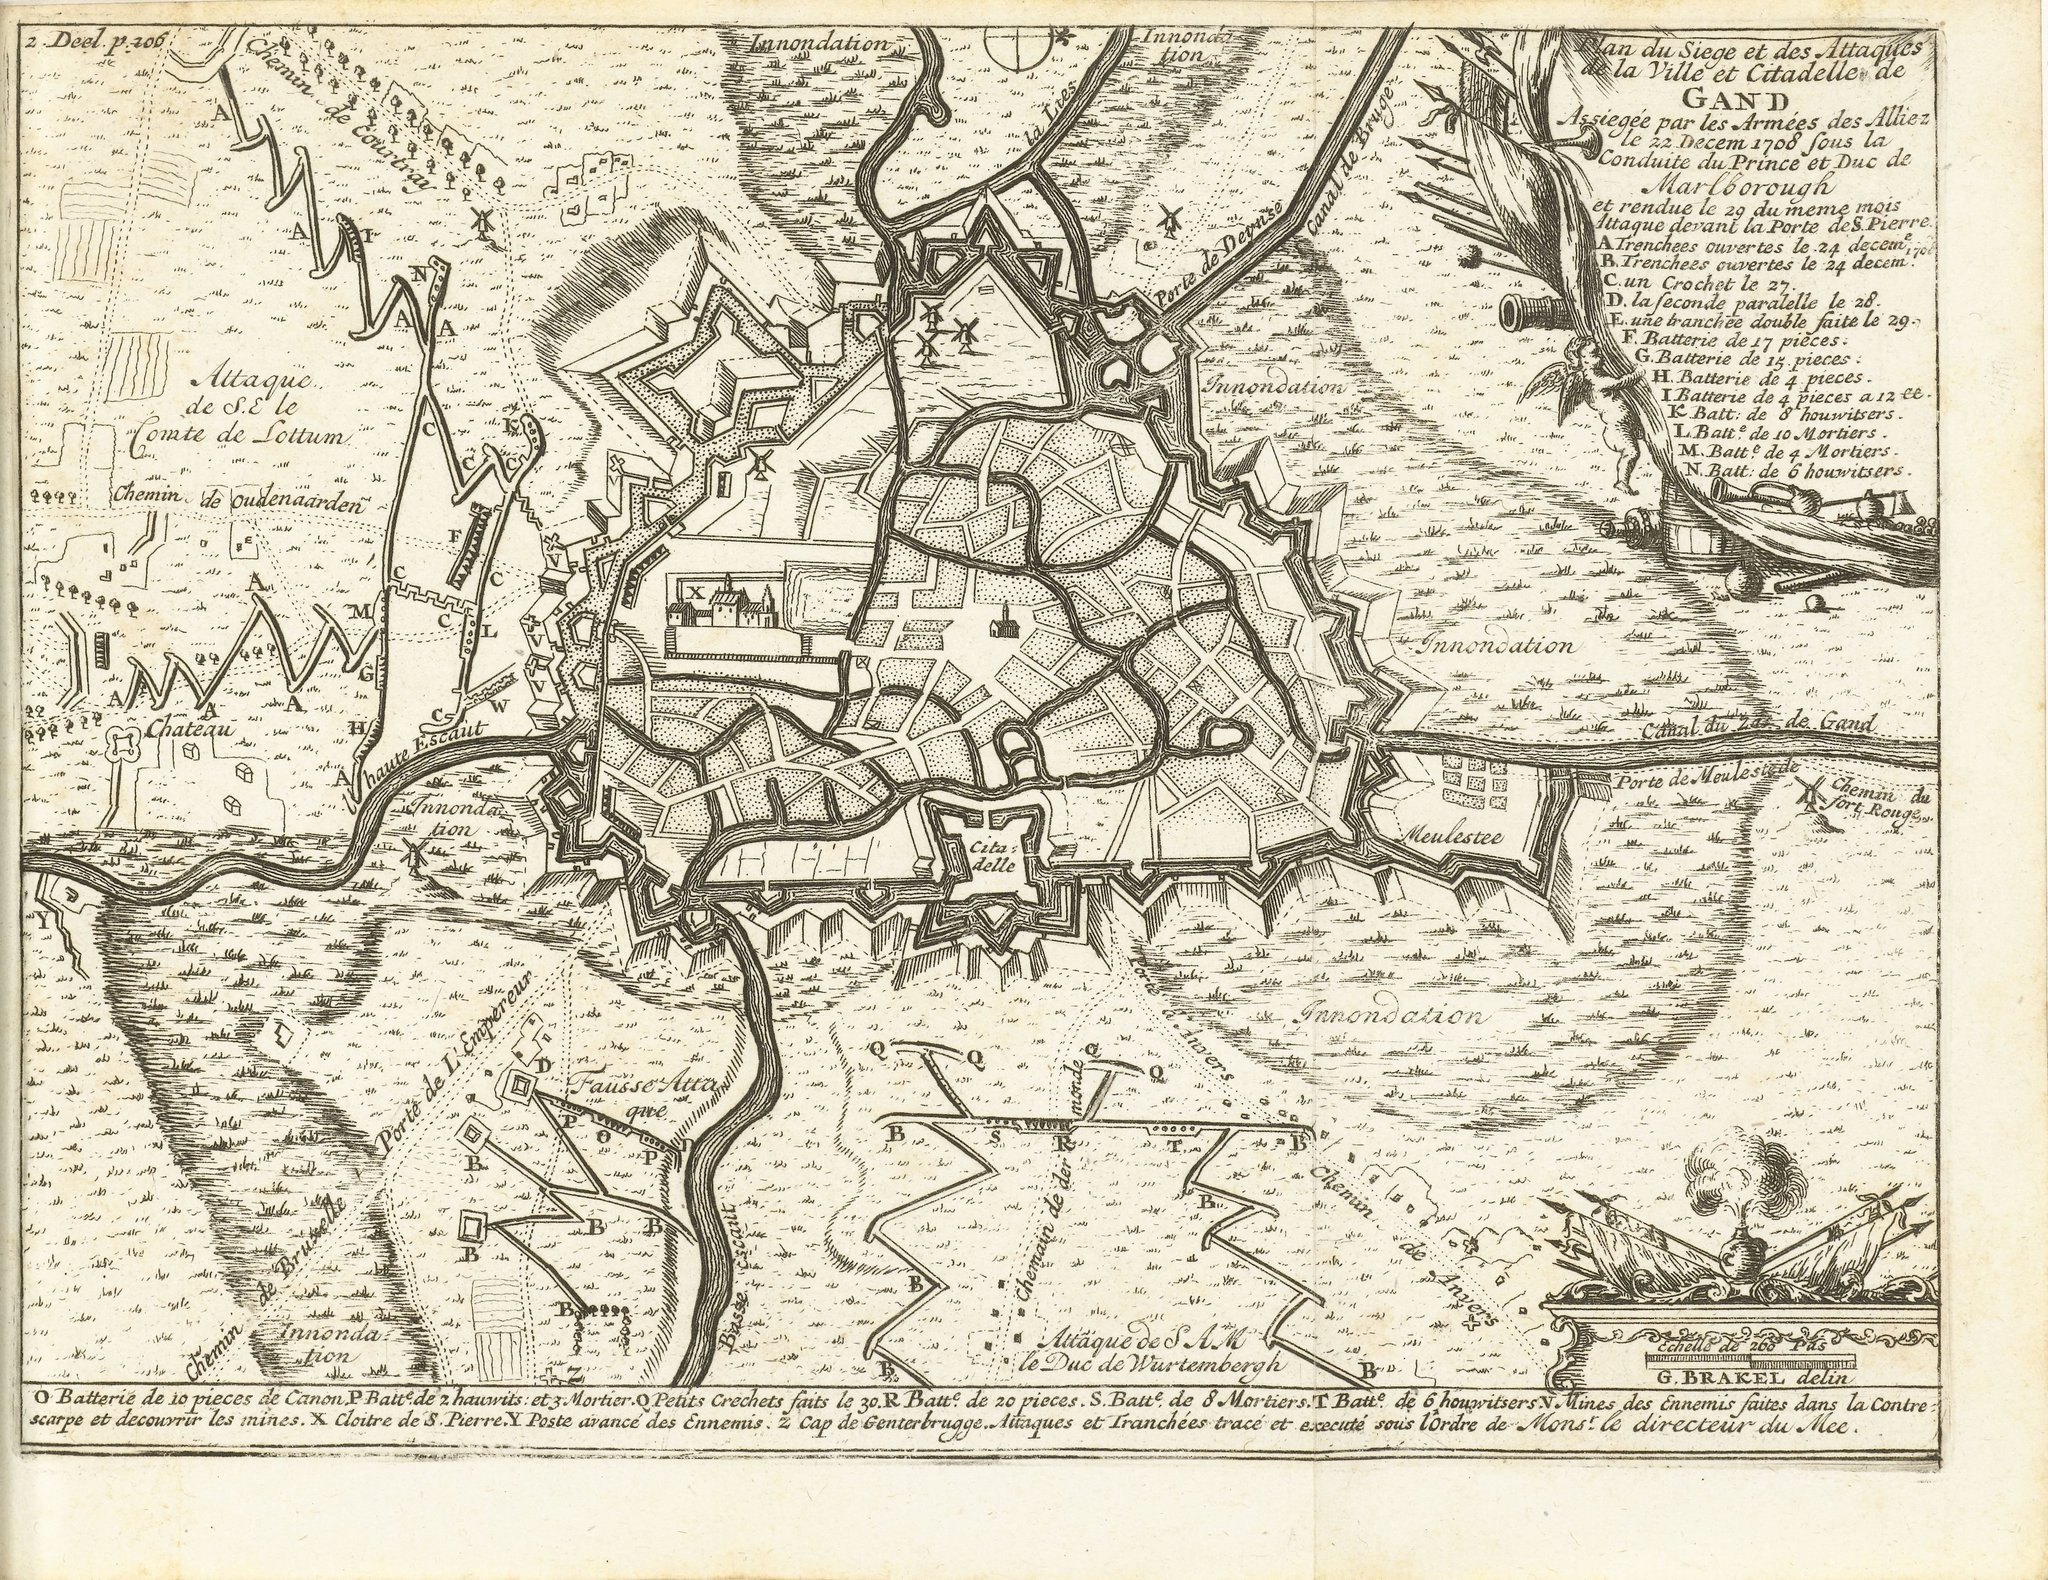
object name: print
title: Beleg van Gent, 1708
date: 1714-1716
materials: paper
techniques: etching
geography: northern netherlands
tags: johan willem friso (prins van oranje-nassau), siege, position war, maps of cities, ghent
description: Plattegrond van Gent, belegerd door de geallieerden en ingenomen op 30 december 1708. Illustratie in de Nederlandse vertaling uit 1716 van J. Lamigue, Het leven van Zyne Hoogheit Johan Willem Friso, dl. II, p. 106/107.